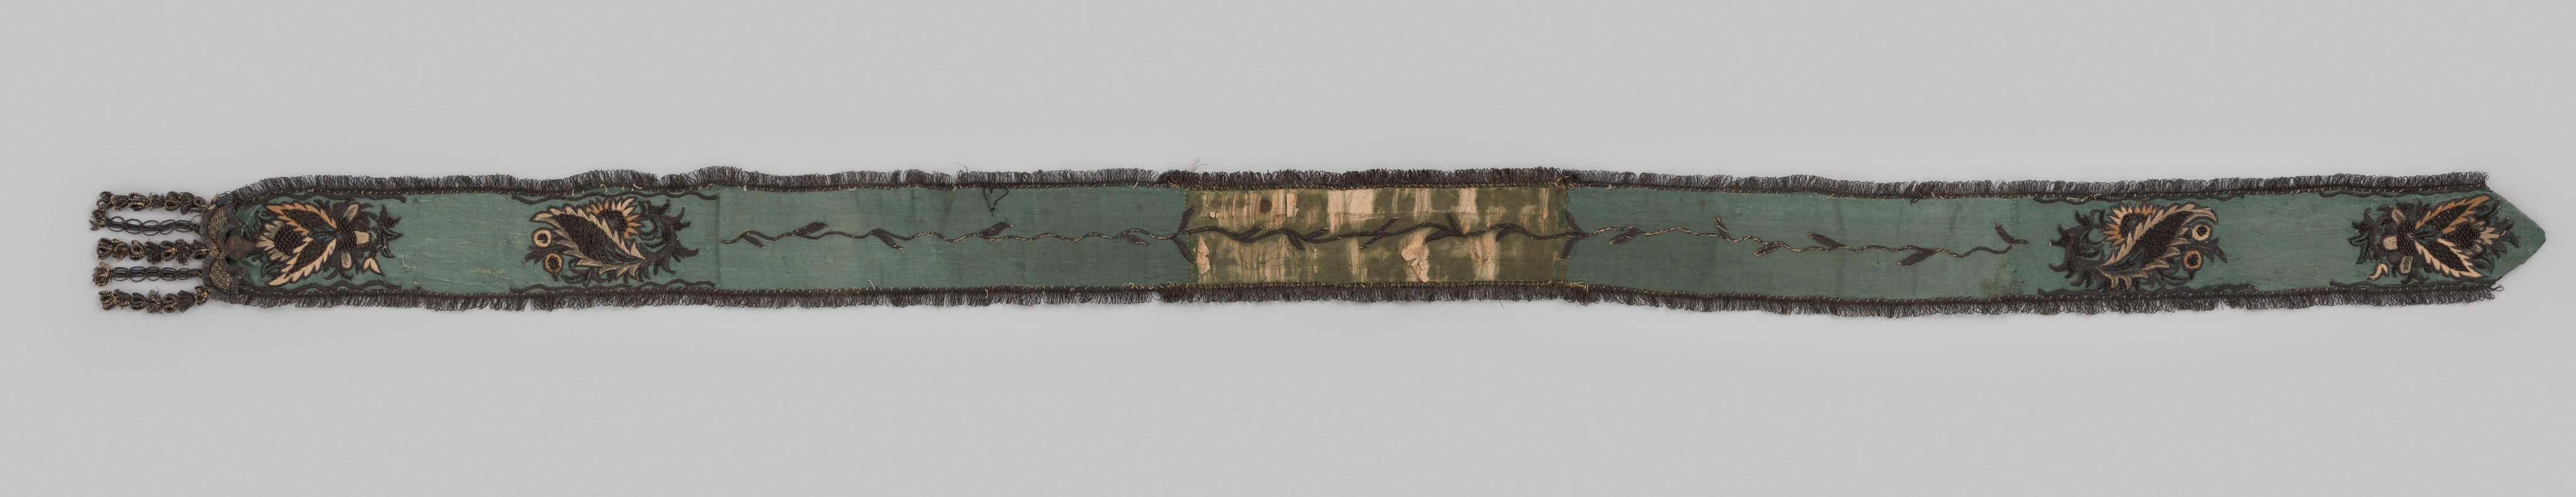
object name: bandolier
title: Bandelier of schelkoord (fragment) van groen zijden ripslint, met florale motieven geborduurd van zilverdraad en vloszijde, aan uiteinde ornament met afhangende slingers, rondom afgezet met lusjesfranje van metaaldraad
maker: Anonymous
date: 1700-1750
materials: cotton, gold thread, paper, silk, thread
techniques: embroidered, weave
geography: western europe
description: Bandelier(?) van groen zijden ripslint. Aan de uiteinden zijn twee motieven in zilverdraad en zalmkleurige zijde geborduurd. Het ene vertoont aan een gekromde stengel een geveerd blad, met halve rozetbloem en twee granaatappels: het tweede vertoont twee uit een halve rozet opstijgende bladeren, die een palmetbloem omvatten. Over de gehele lengte loopt een golvende tak met blad. Afwerking langs de zijkanten met lusjesfranje en aan één korte zijde een franje van goud en zilverdraad, met als hoofdje een eikelpalmet, als lichaam een geschulpt veld met rastervulling en als sneden vijf torsades. Het zilverdraad is in drie typen: glad metaalreepje om zijden kern, cannetille en plat metalen bandje.